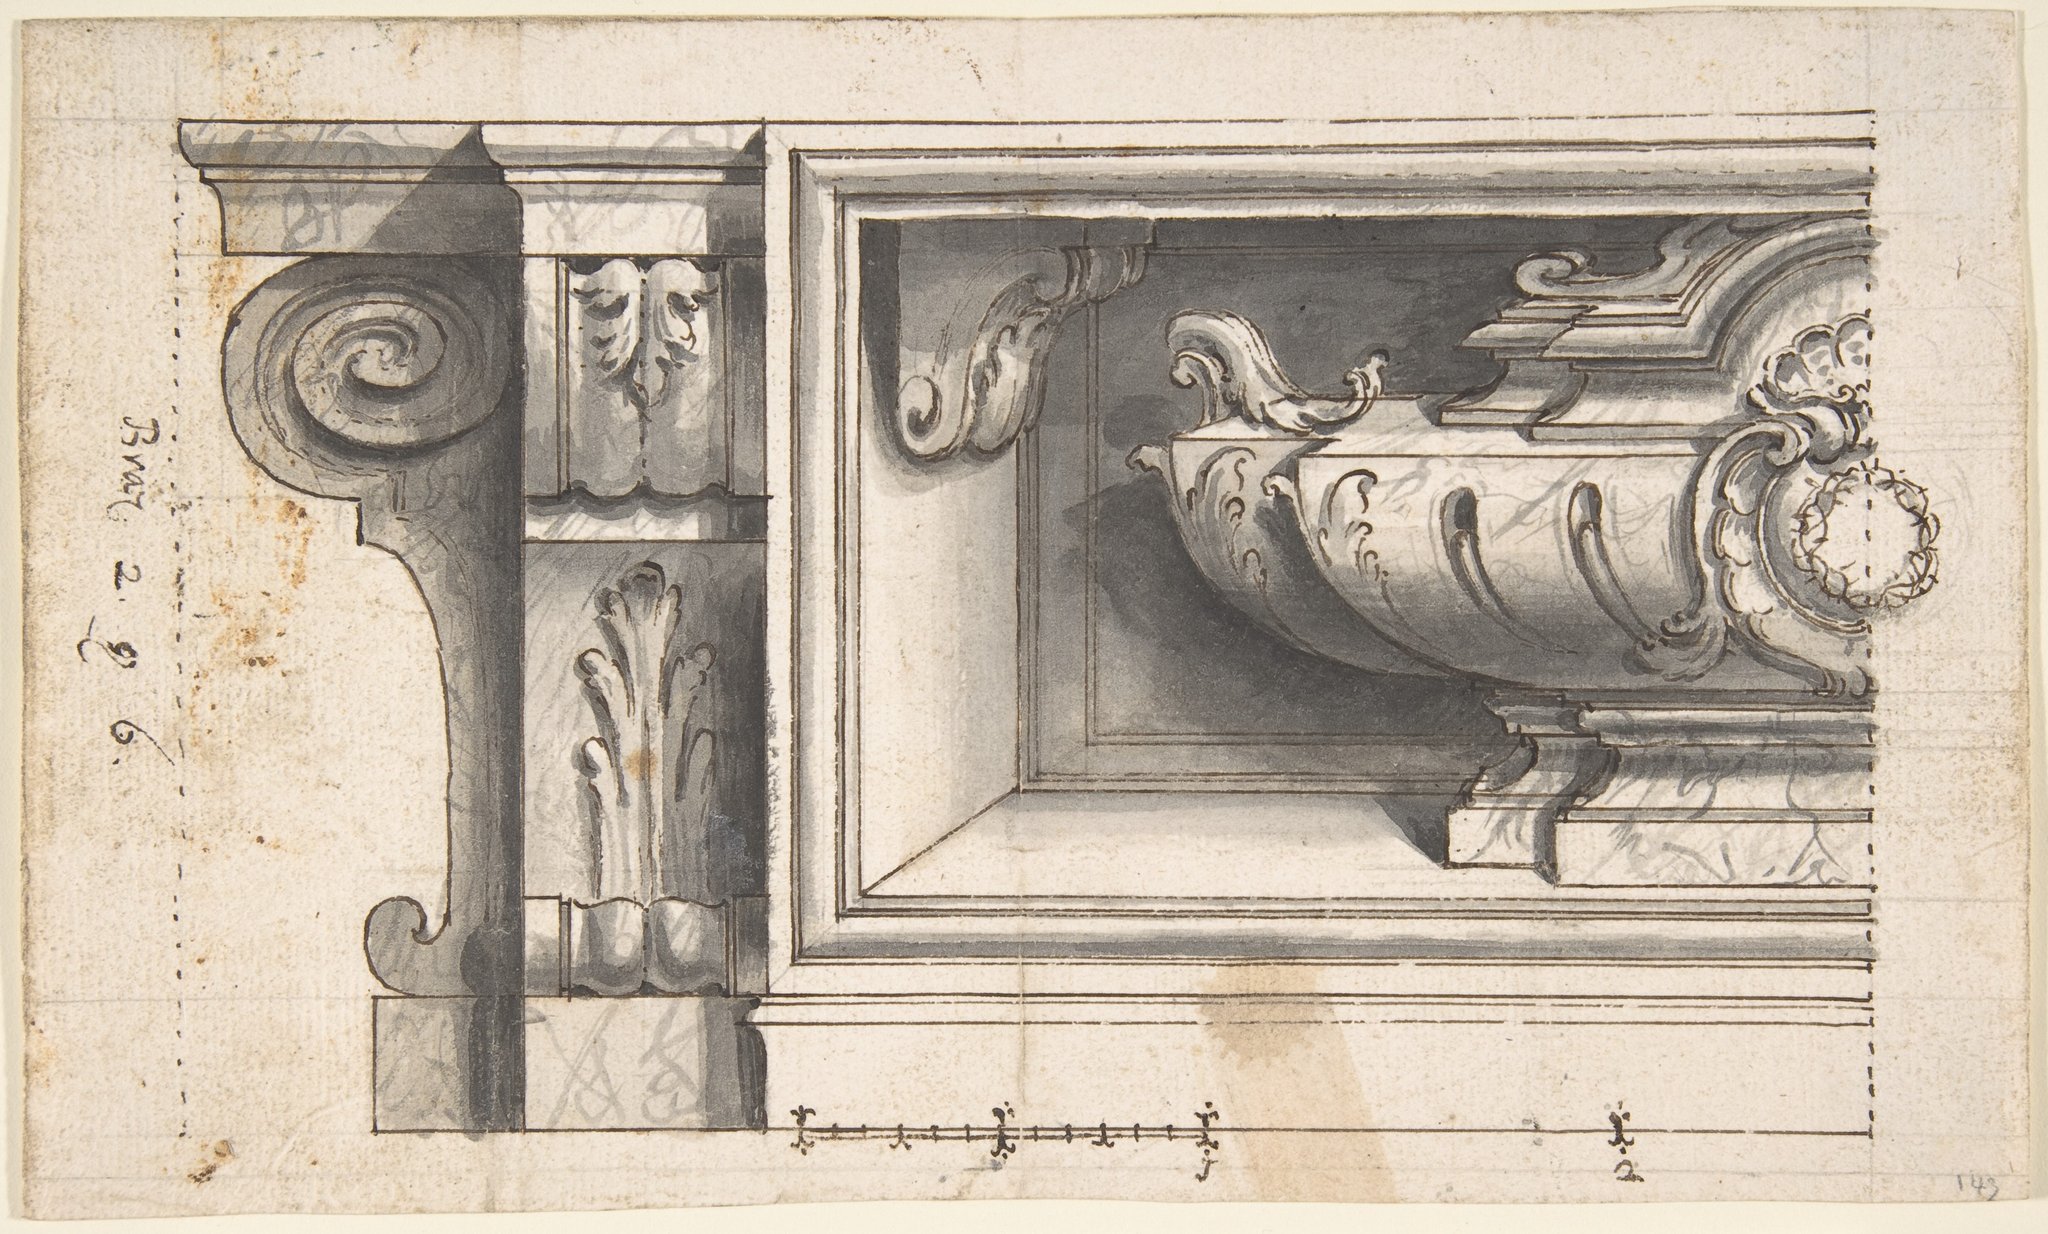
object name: drawing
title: Design for a Sarcophagus or an Urn in a Niche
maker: anonymous, italian, piedmontese, 18th century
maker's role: artist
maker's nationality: italian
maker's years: 1700-1800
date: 1700-1780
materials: graphite, ink, drawing material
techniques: brush, pen, wash